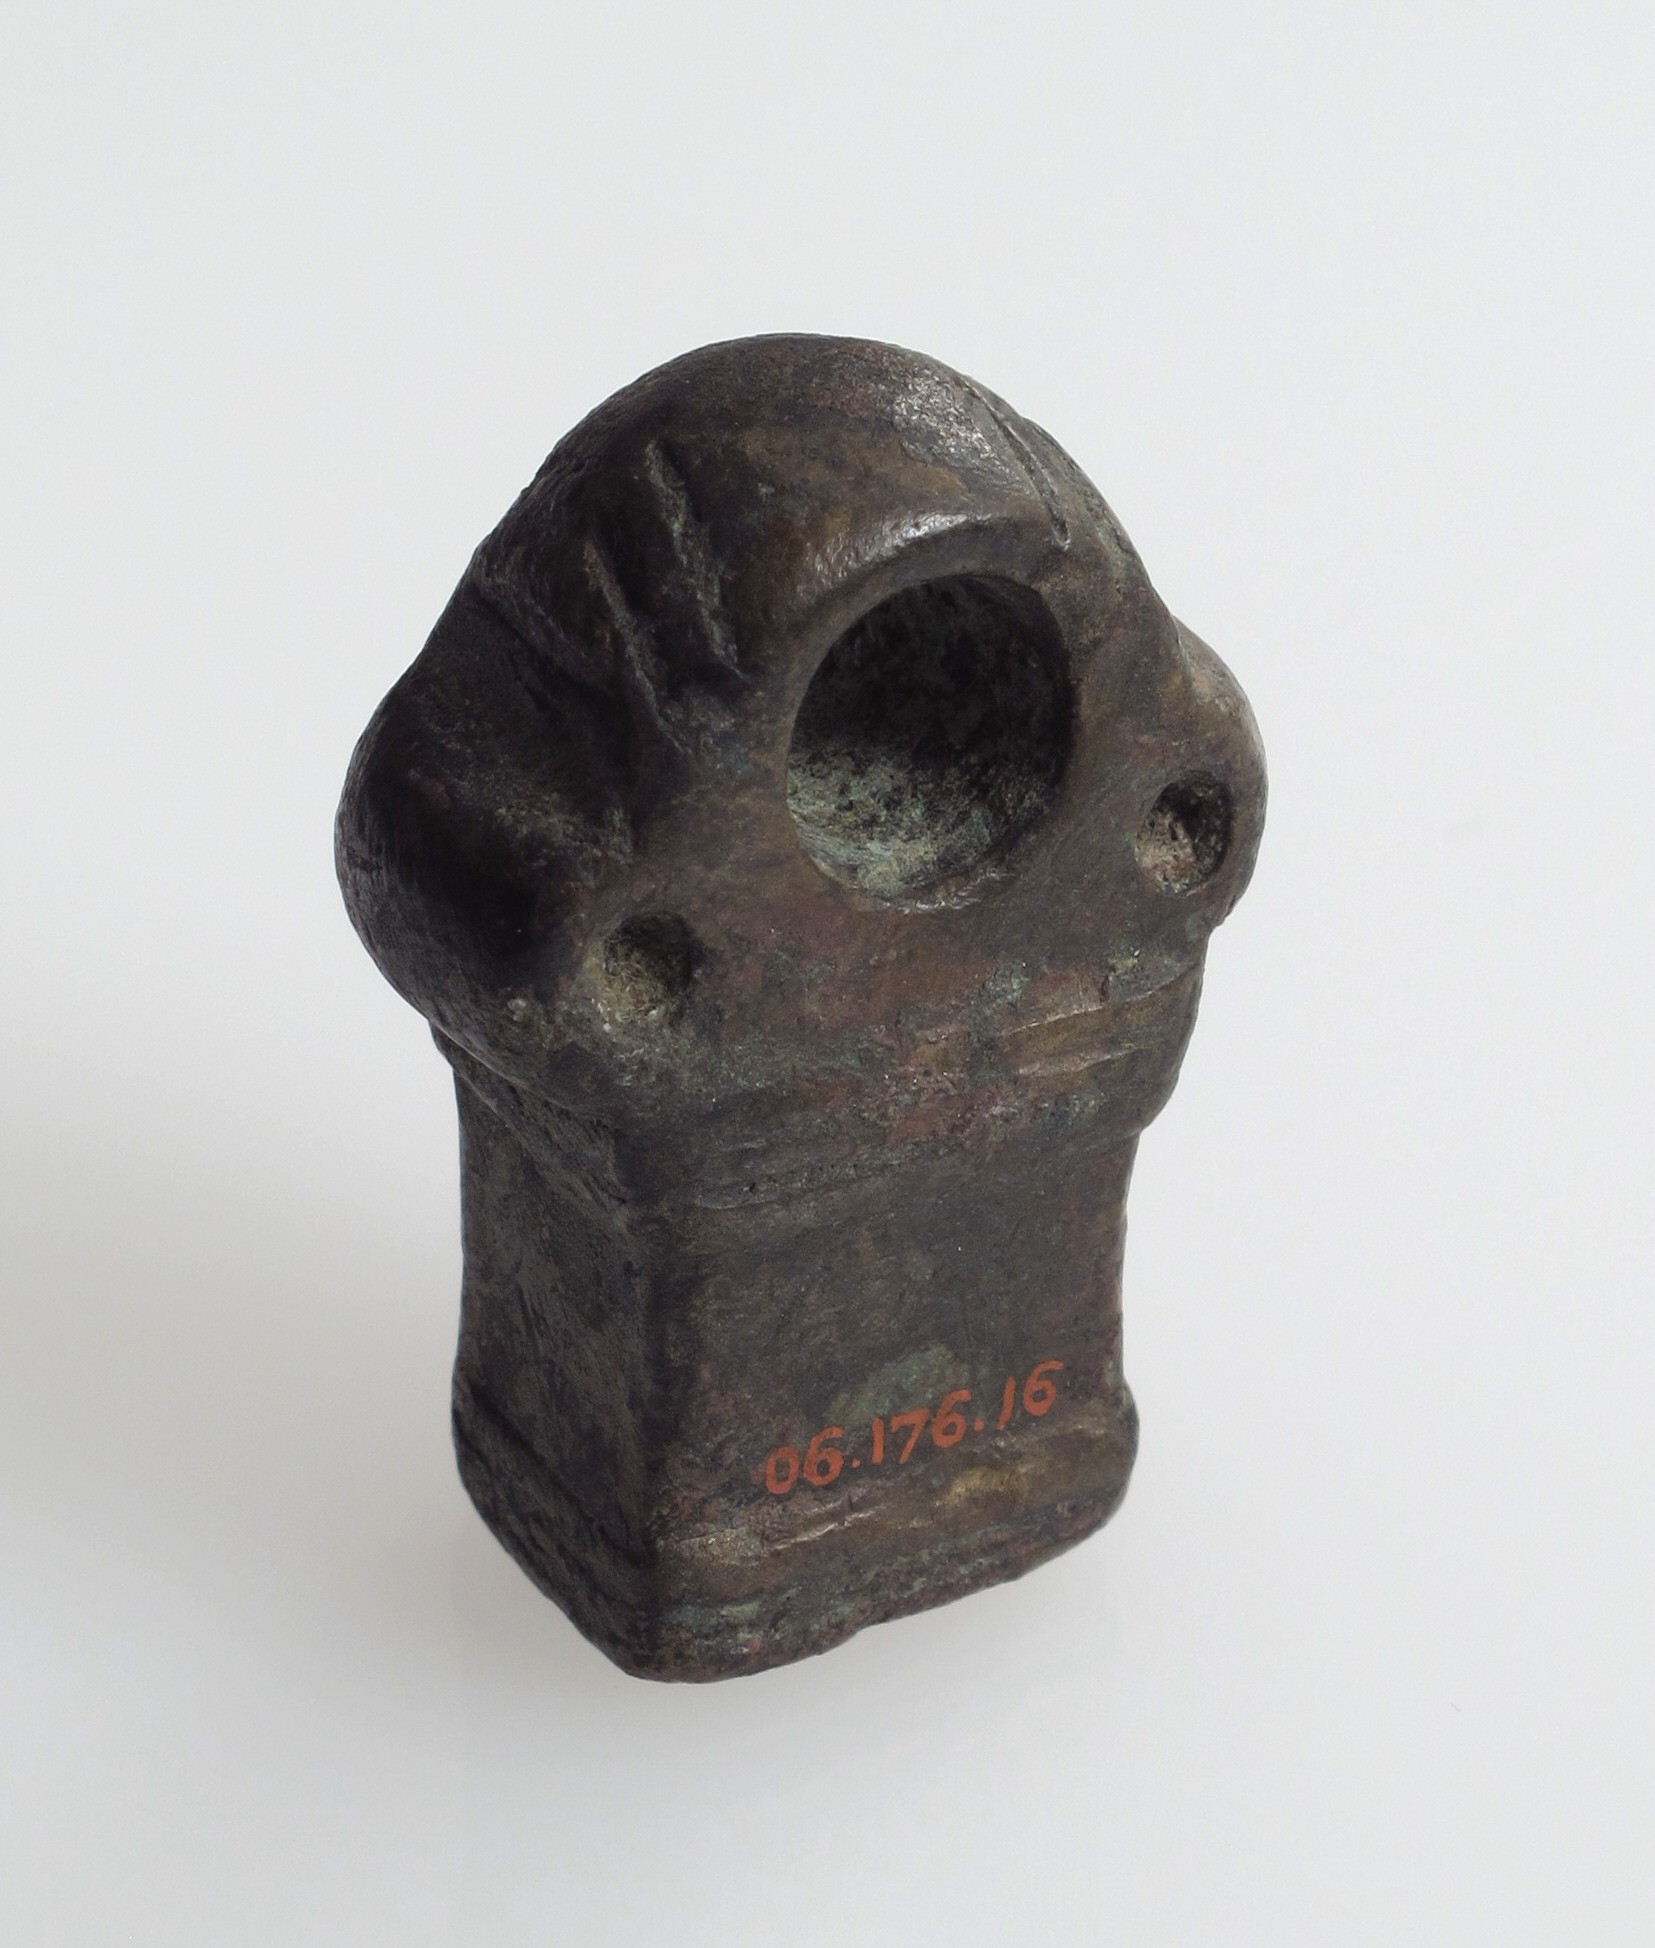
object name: key handle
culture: roman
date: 1-700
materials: copper alloy